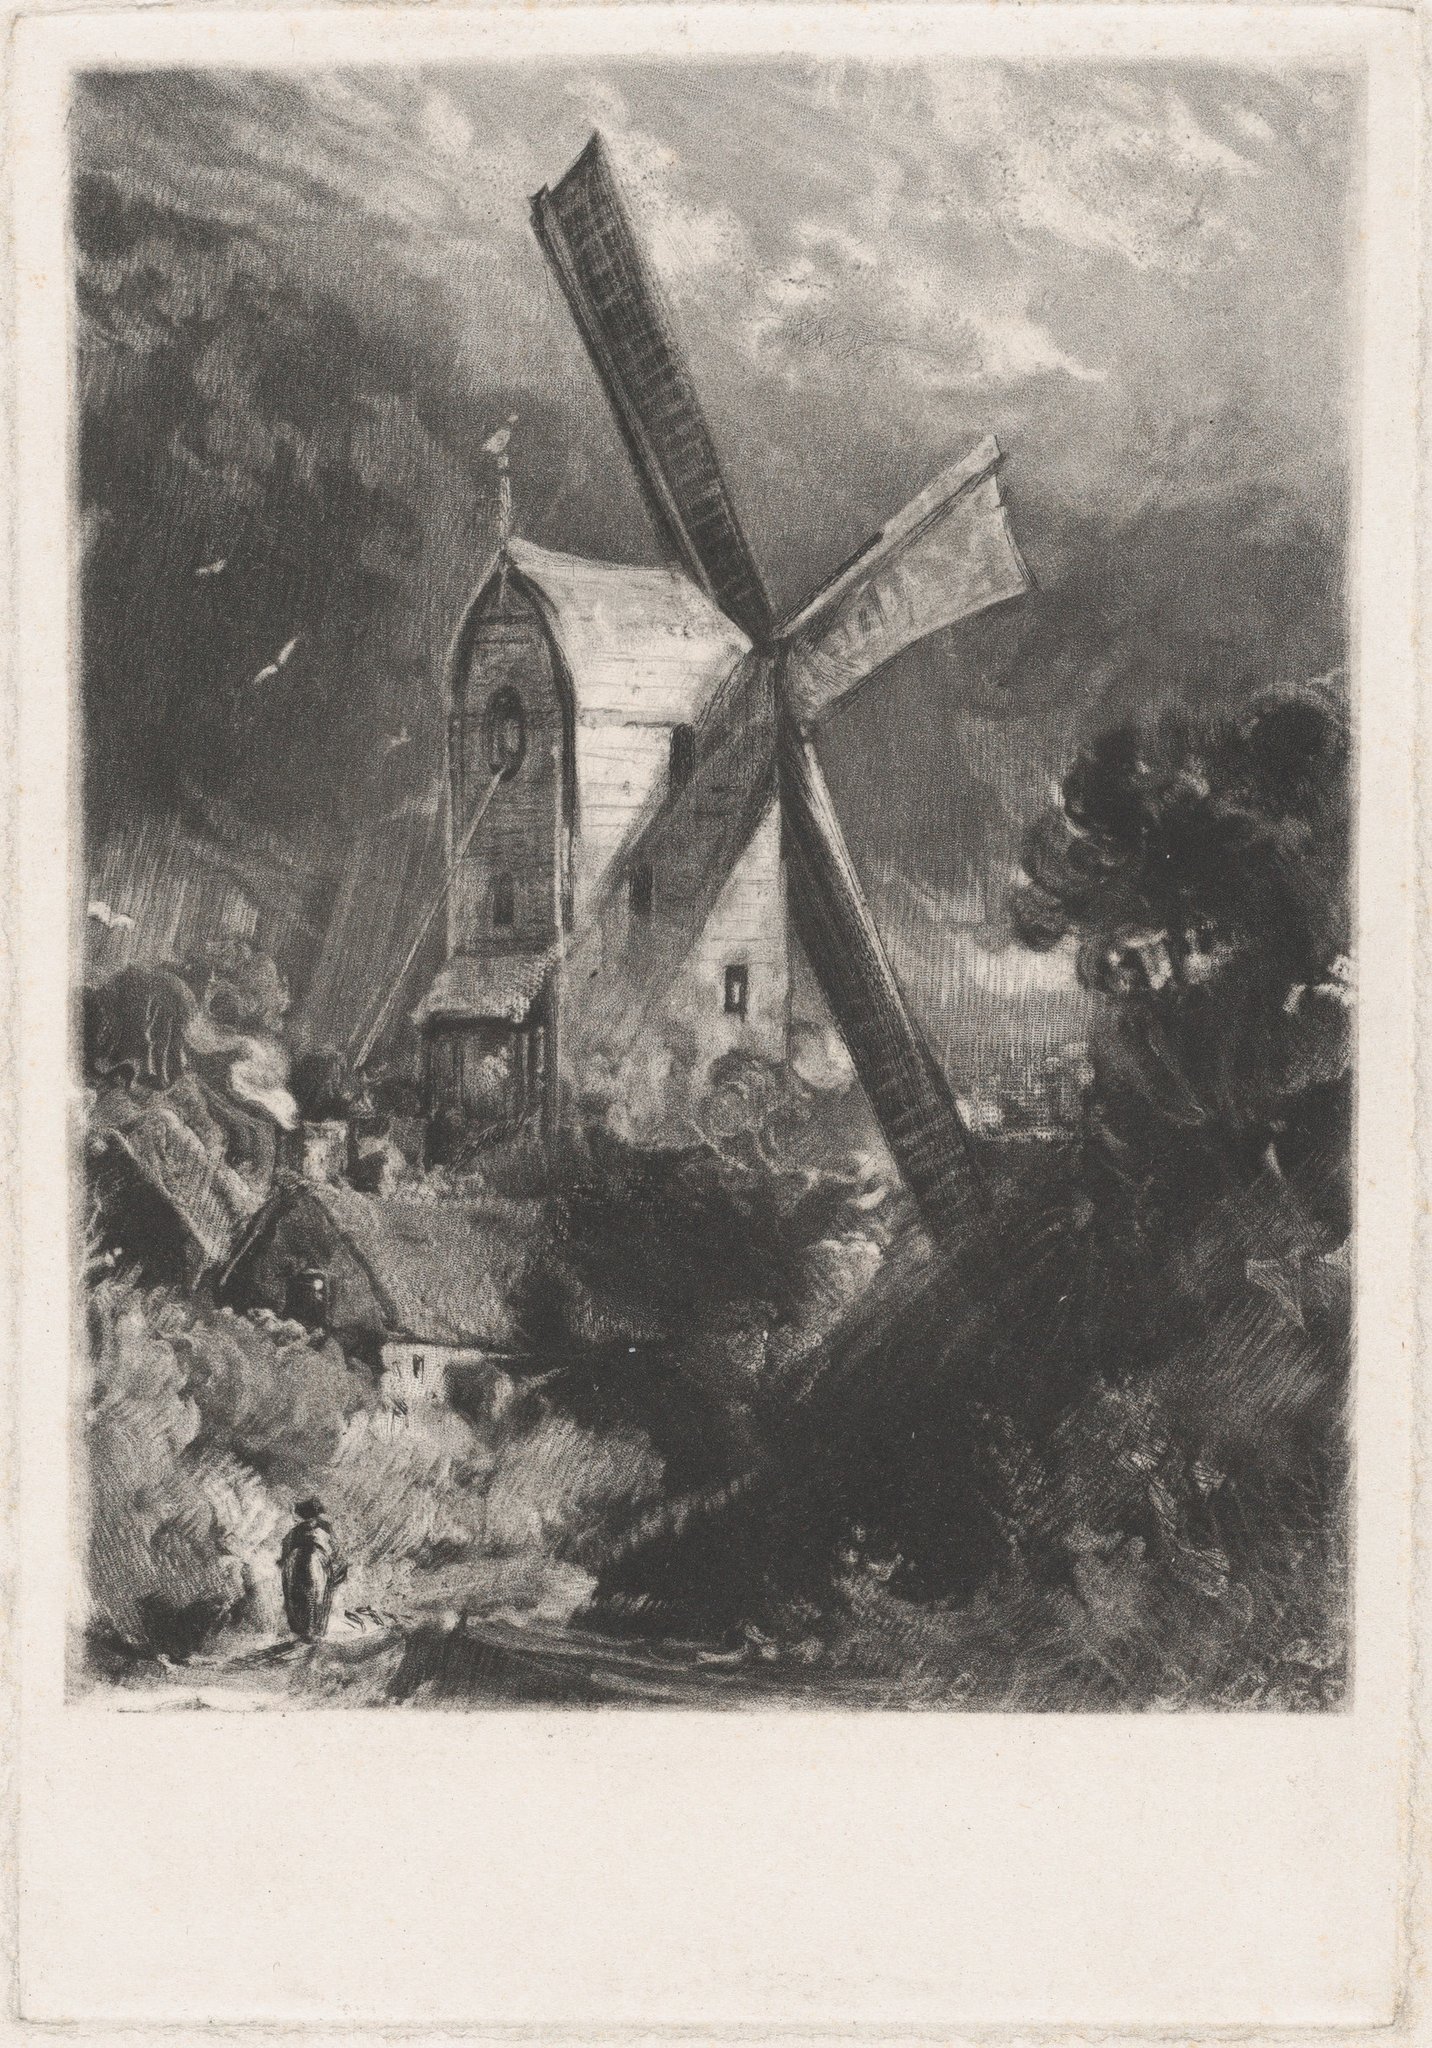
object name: print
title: Mill Near Brighton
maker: david lucas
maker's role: artist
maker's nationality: british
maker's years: 1802-1881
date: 1829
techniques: mezzotint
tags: windmills